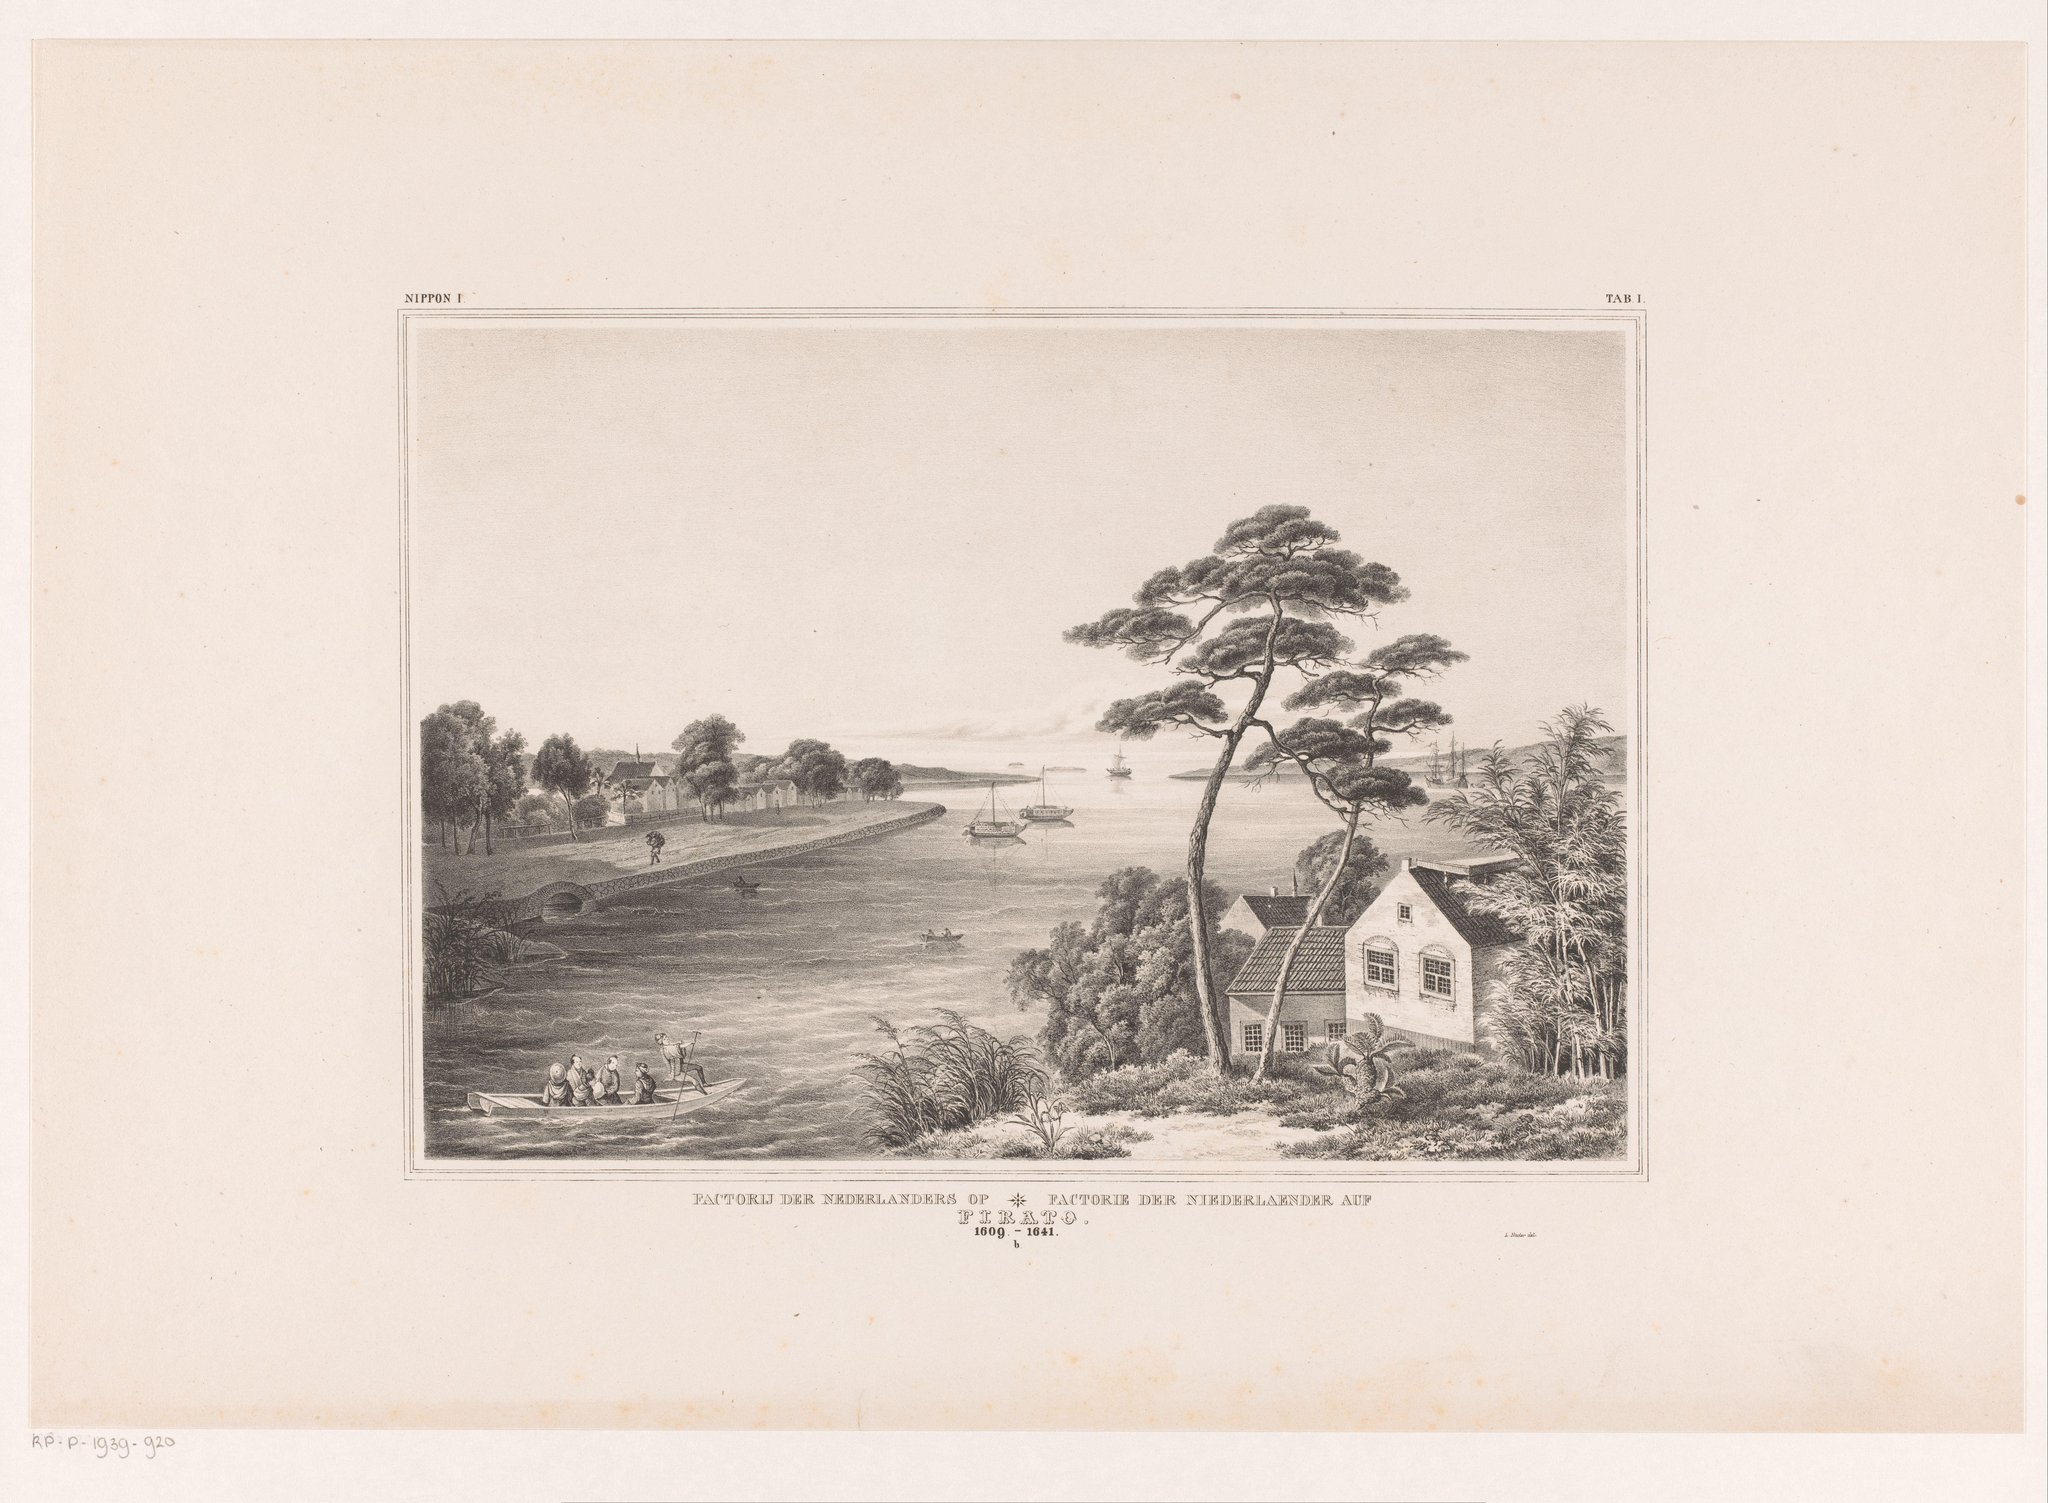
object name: book illustration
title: Nederlandse factorij op eiland Hirado (Firato)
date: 1832-1852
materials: paper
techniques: lithograph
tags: trade-company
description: Prent uit: Siebold, Philipp Franz von. Nippon, Archiv zur Beschreibung von Japan und dessen Neben- und Schutzländers. Leiden en Amsterdam: S.n., 1832-1852.